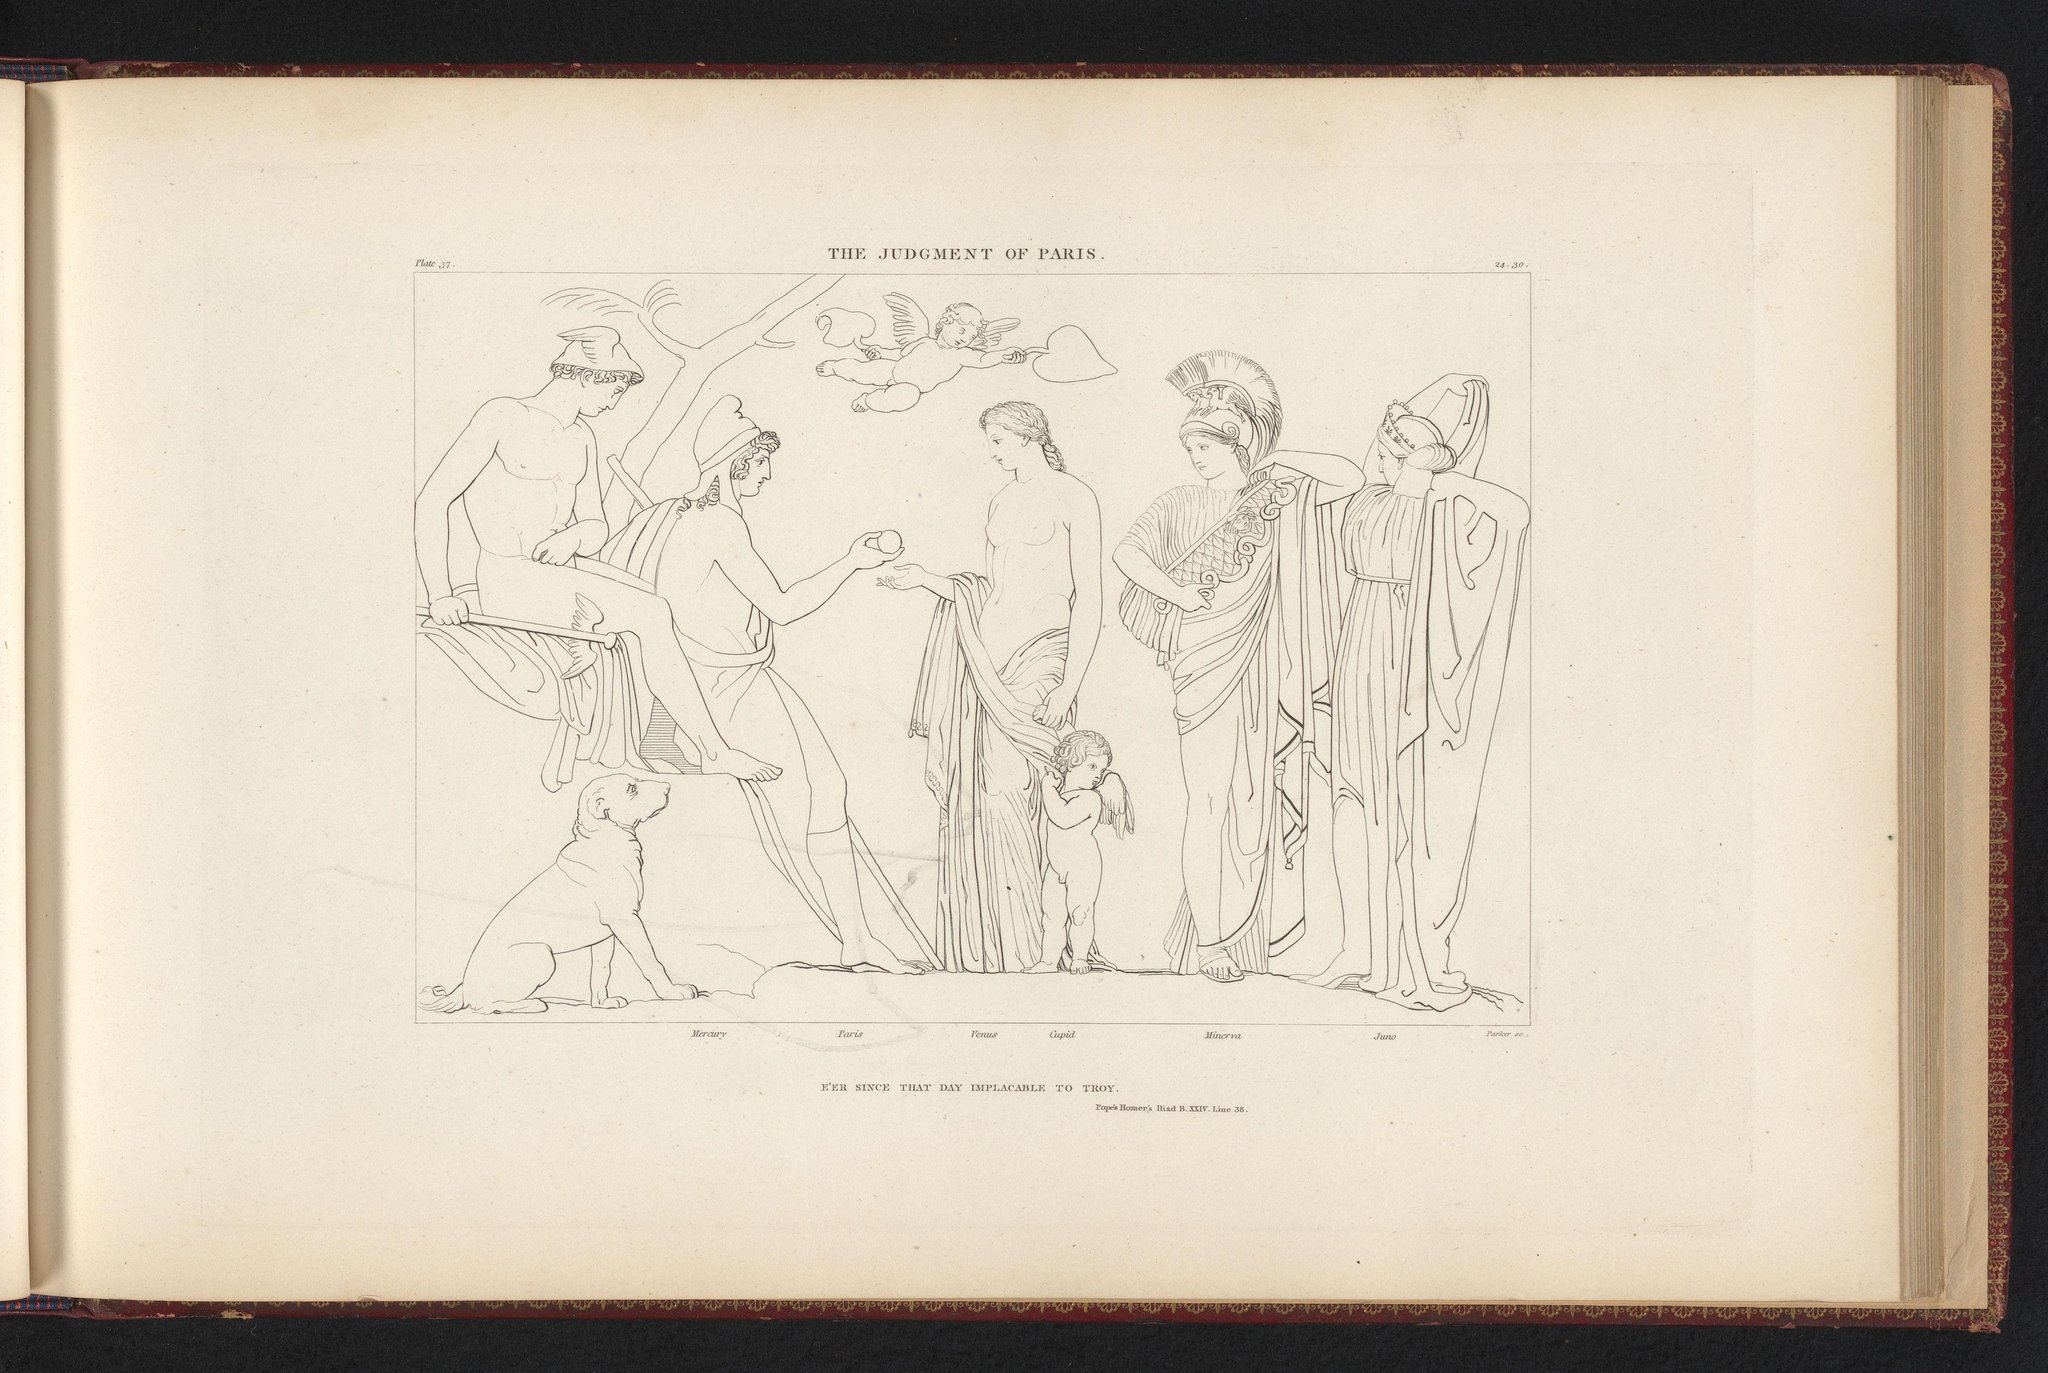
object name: album leaf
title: Iliad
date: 1805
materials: paper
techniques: etching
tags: the judgement of paris (mercury present)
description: Prent maakt onderdeel uit van een serie met 39 prenten over de Ilias, geschreven door Homerus.